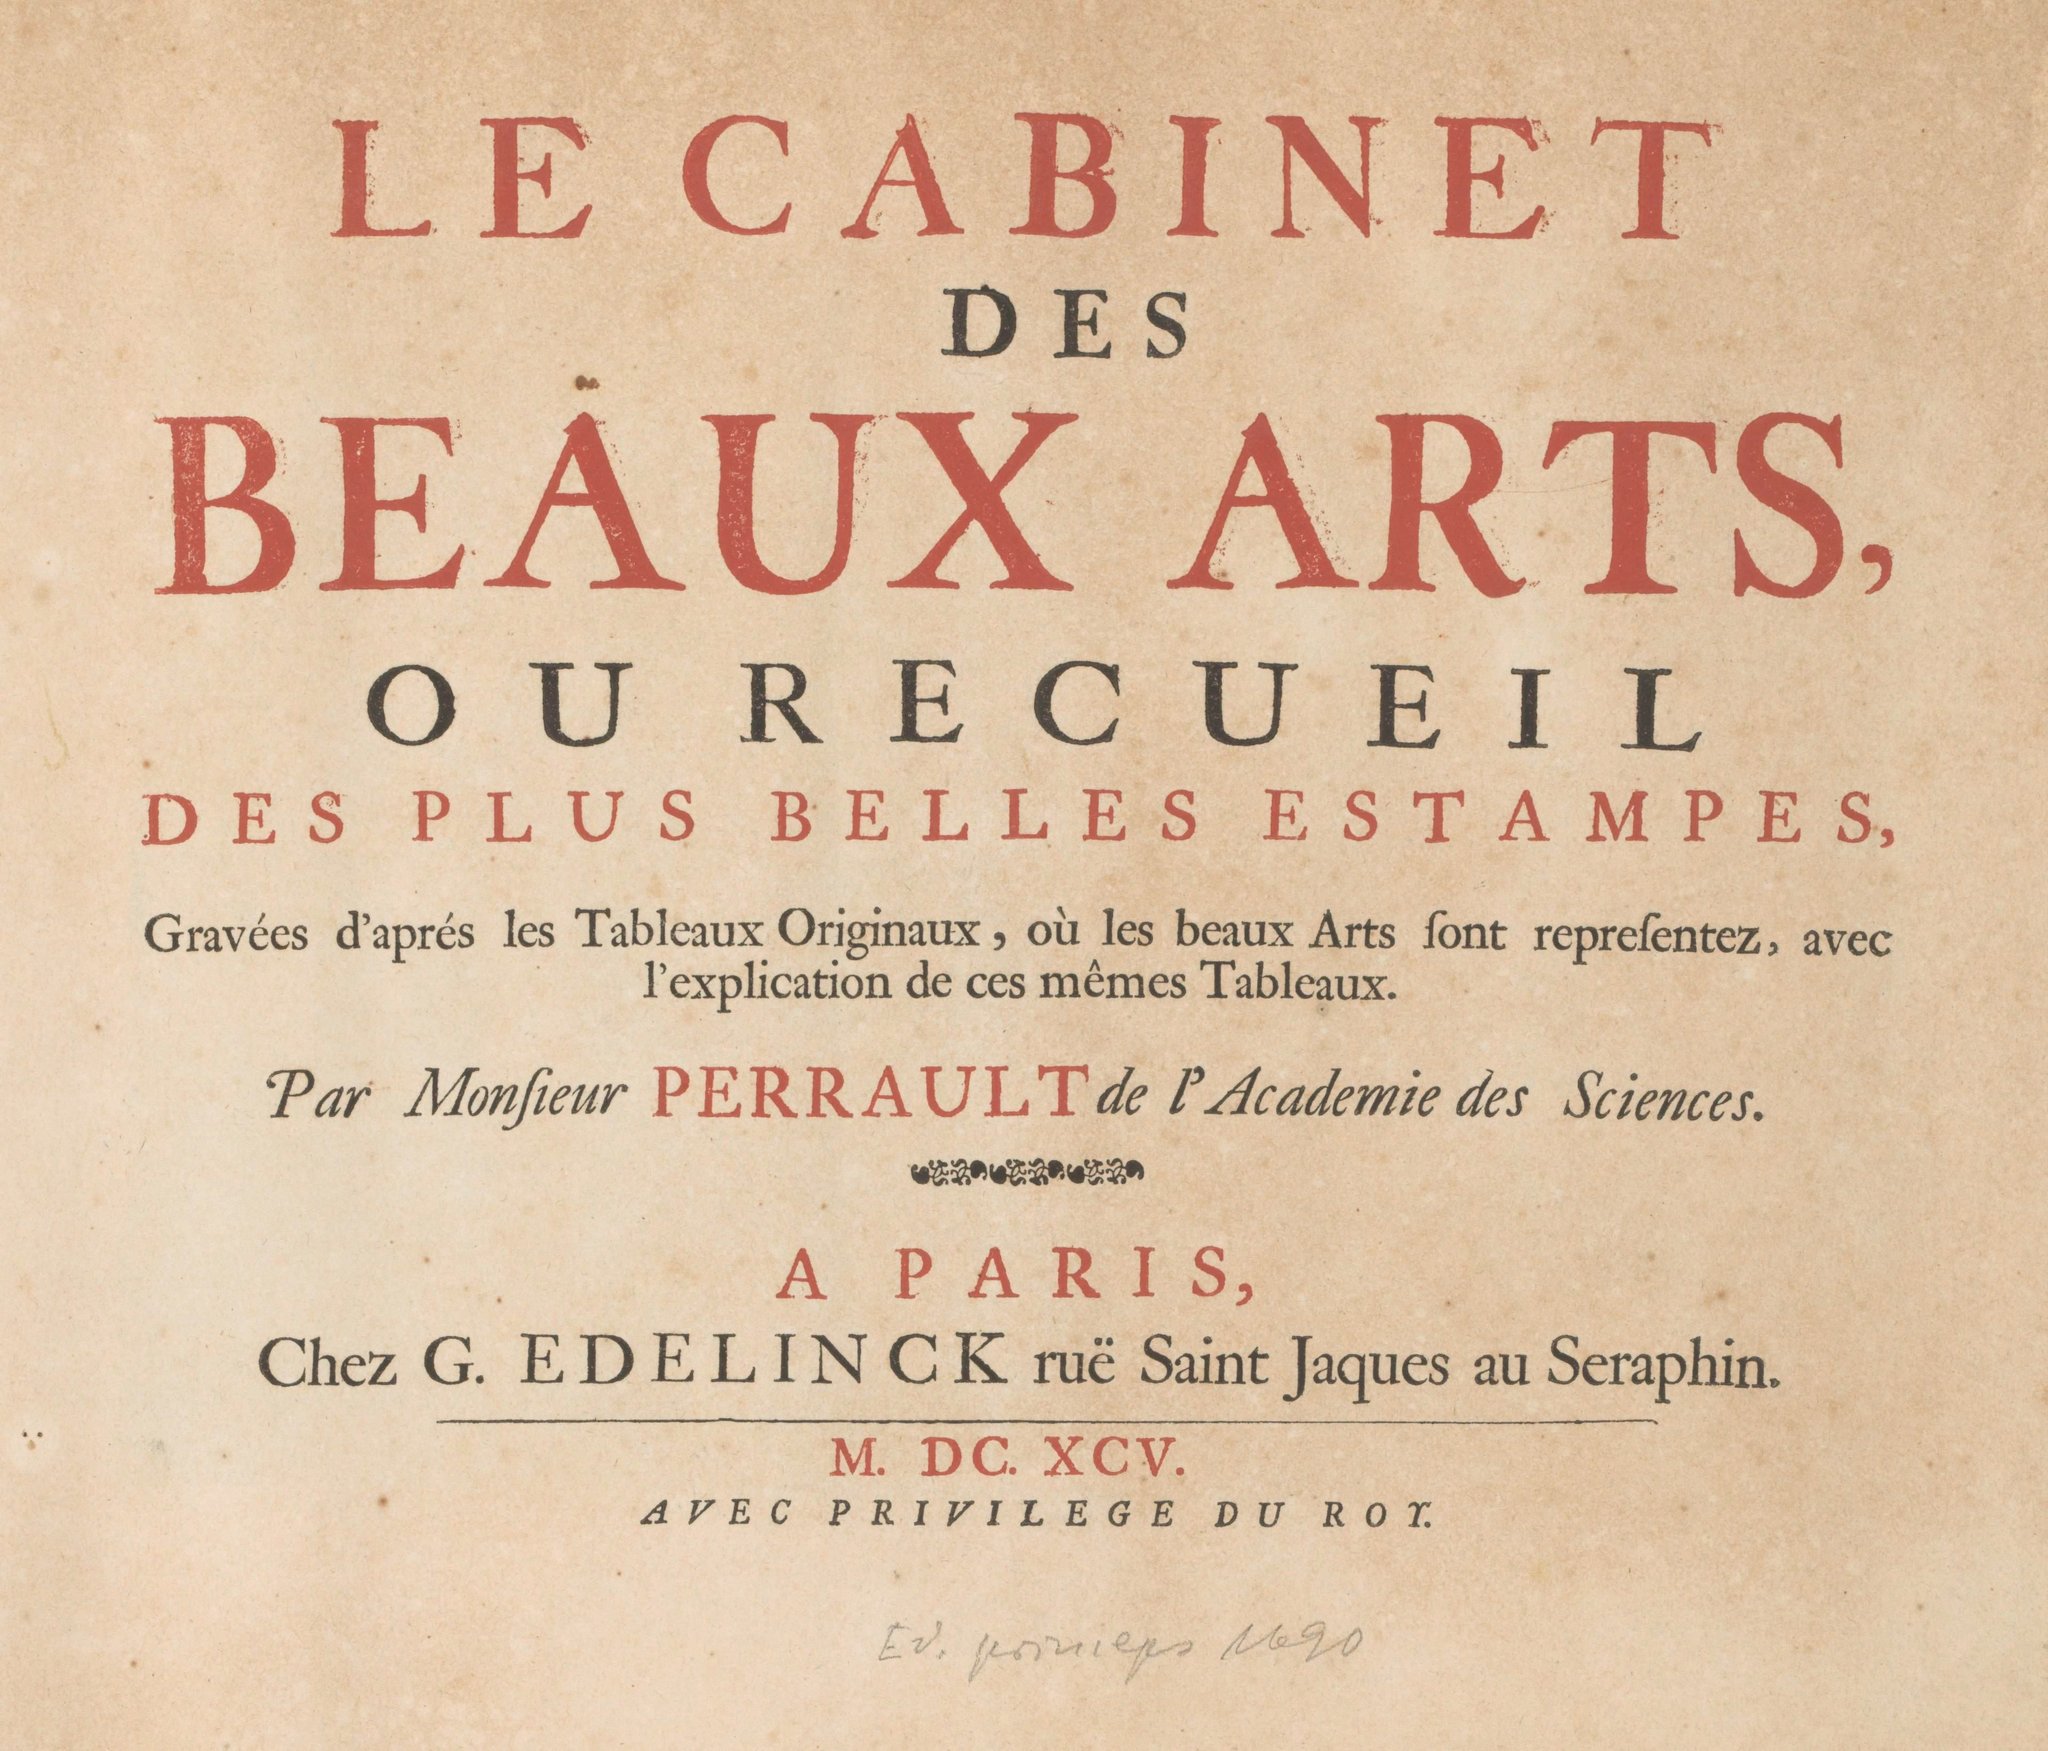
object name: album leaf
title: Titelpagina voor: C. Perrault, Le Cabinet des Beaux Arts, ou Recueil Des Plus Belles Estampes, gravées d'aprés les Tableaux Originaux, òu les beaux Arts sont representez, avec l'explication de ces mêmes Tableaux, 1695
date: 1695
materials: paper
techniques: letterpress printing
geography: paris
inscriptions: collector's mark: Lugt 2166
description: Titelpagina maakt deel uit van een album.